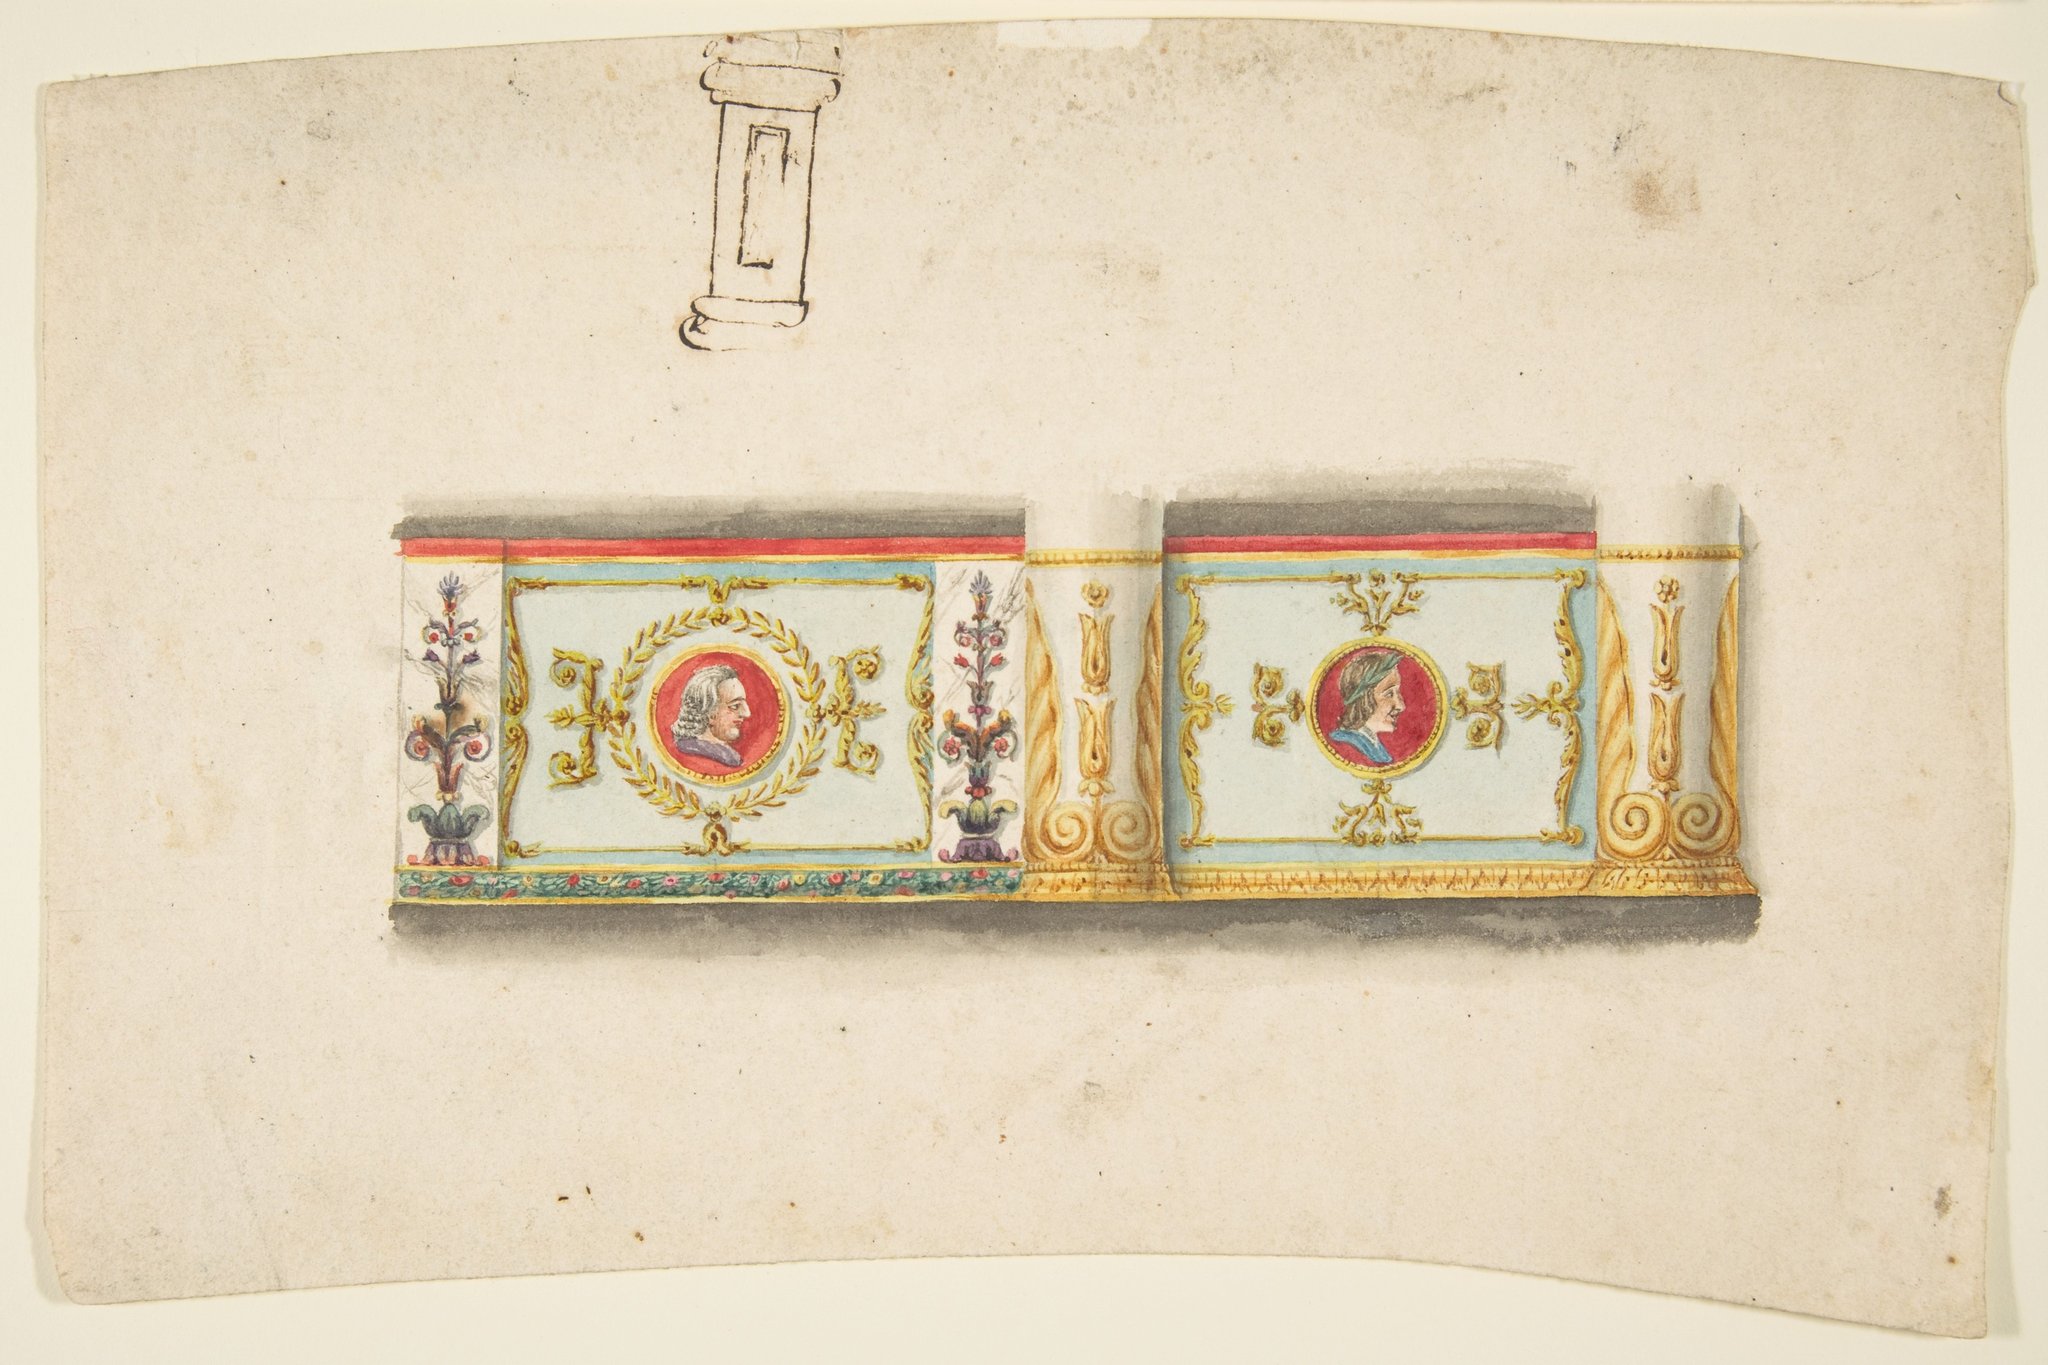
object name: drawing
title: Design for a Decorative Wall Panel with Profile Portraits, and a Study for a Column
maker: anonymous, french, 19th century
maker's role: artist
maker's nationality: french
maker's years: 1800-1900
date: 1801-1900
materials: ink, watercolor, paper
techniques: pen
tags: men,profiles